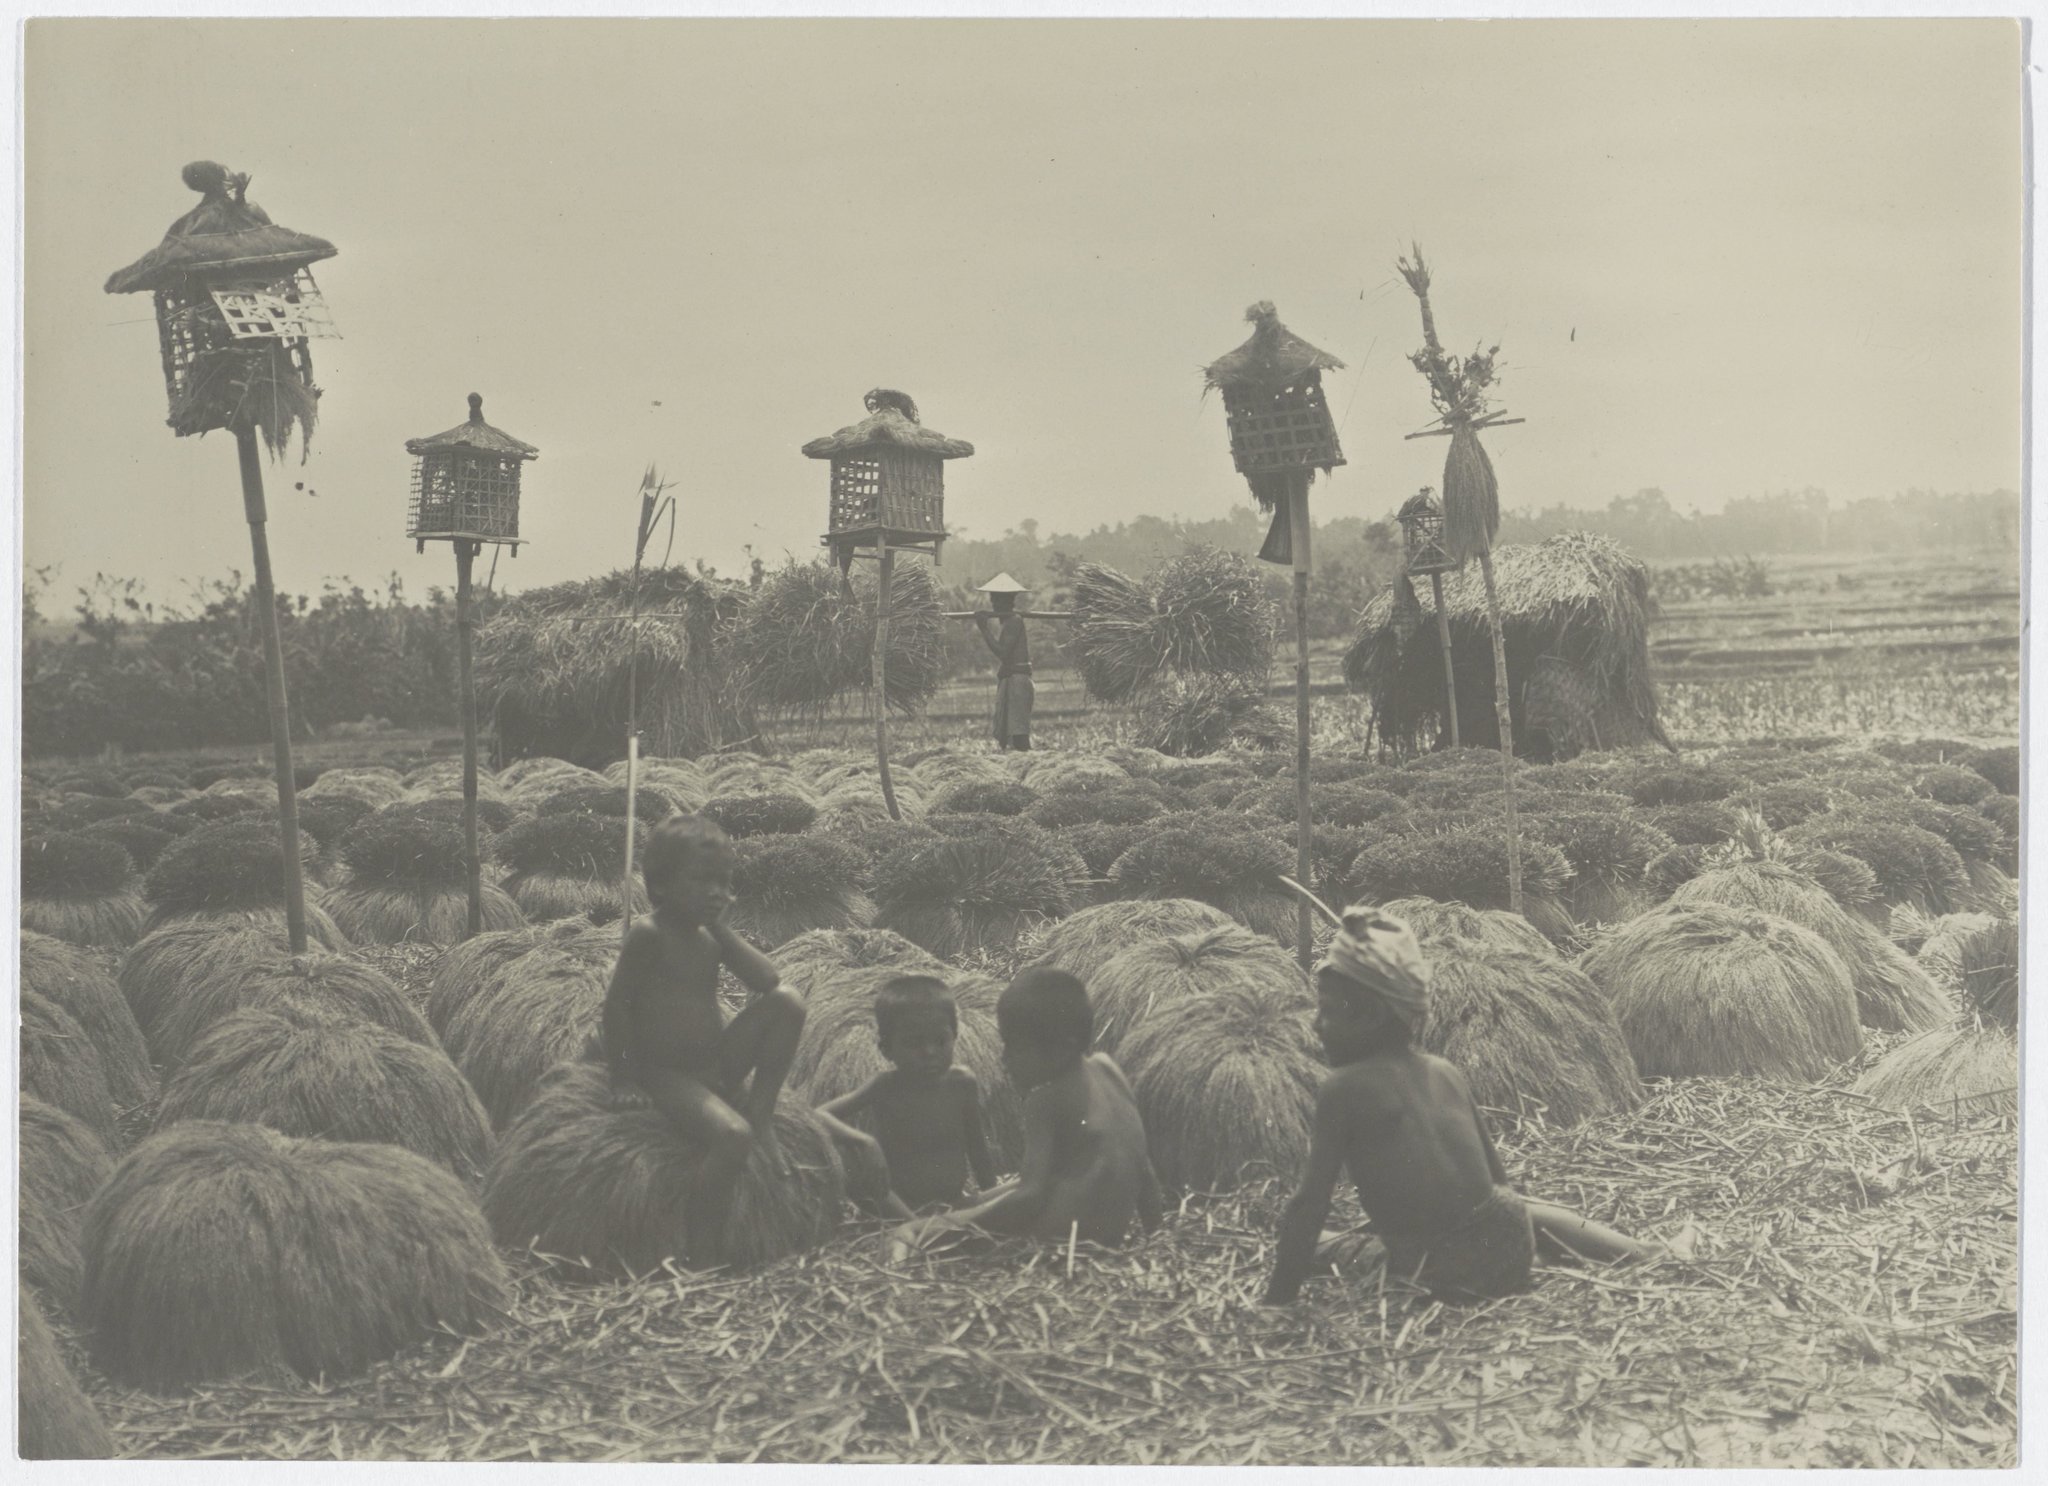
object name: photograph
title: Paddie veld met huisjes voor de geesten.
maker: Anonymous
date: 1890-1915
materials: cardboard, paper, photographic support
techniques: albumen print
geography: indonesia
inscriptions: title: ‘paddie veld met huisjes voor de geesten.’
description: Jonge jongens spelen in een padi veld met geestenhuisjes waar gewerkt wordt aan de oogst. In het veld staan geestenhuisjes op een stok, waarschijnlijk ter bescherming van de padi oogst.